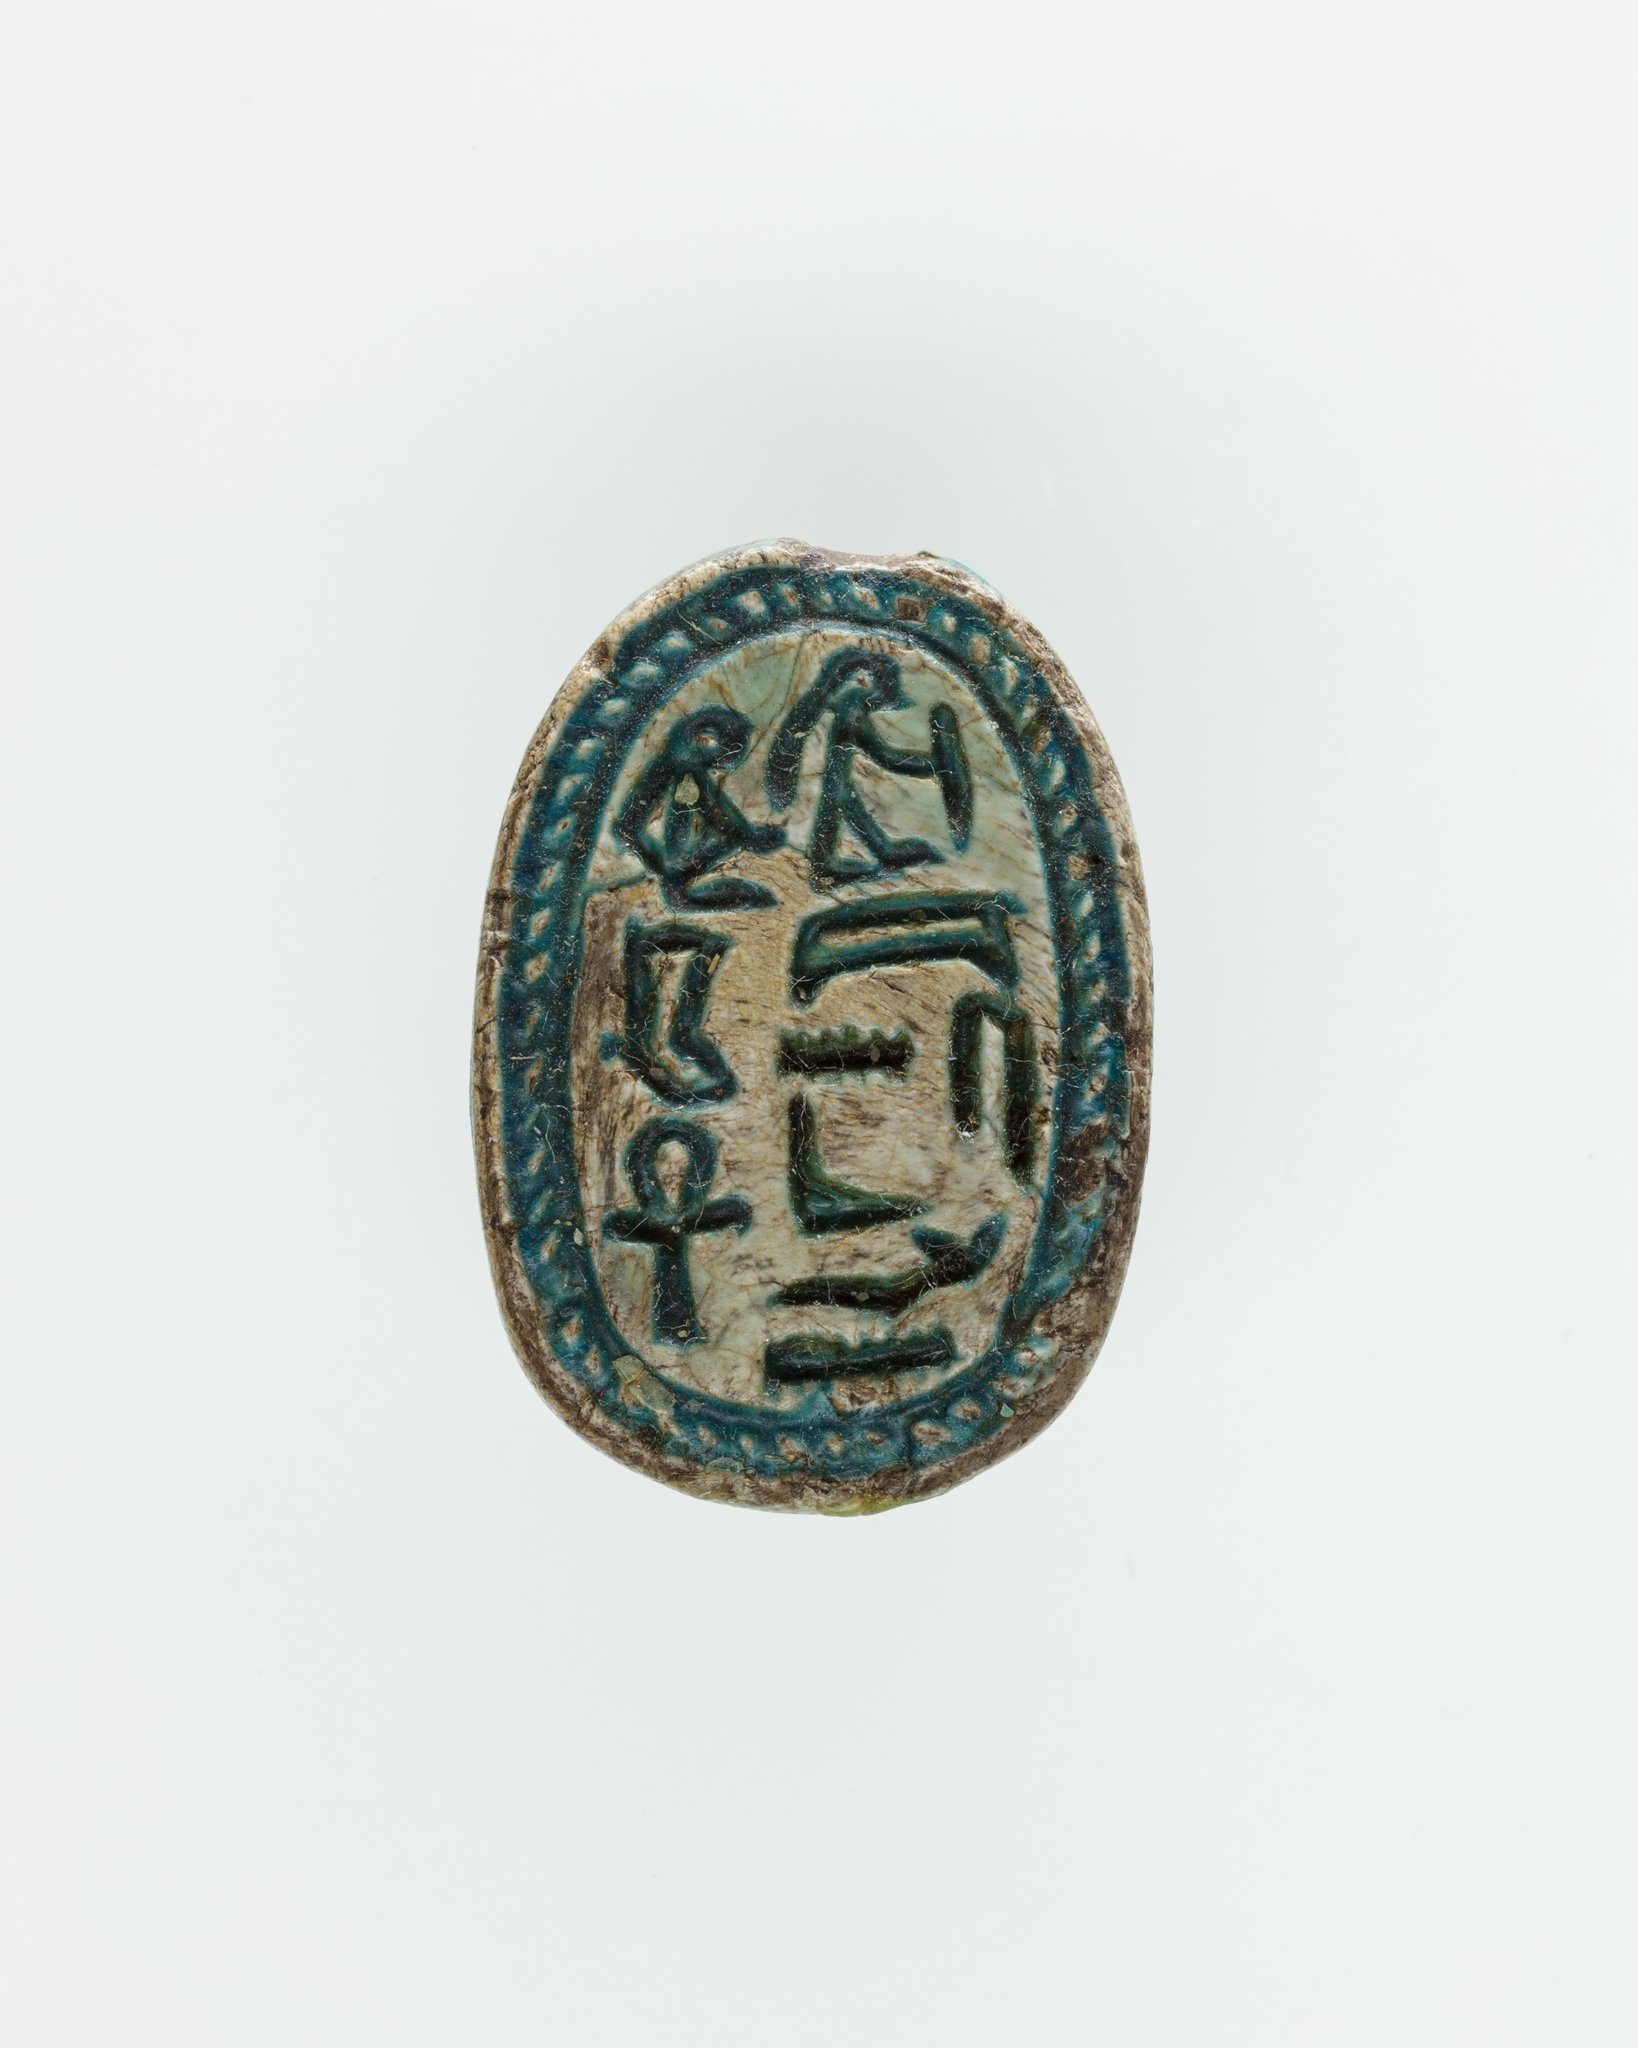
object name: scarab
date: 1640-1550 BCE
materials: stone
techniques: glazing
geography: egypt